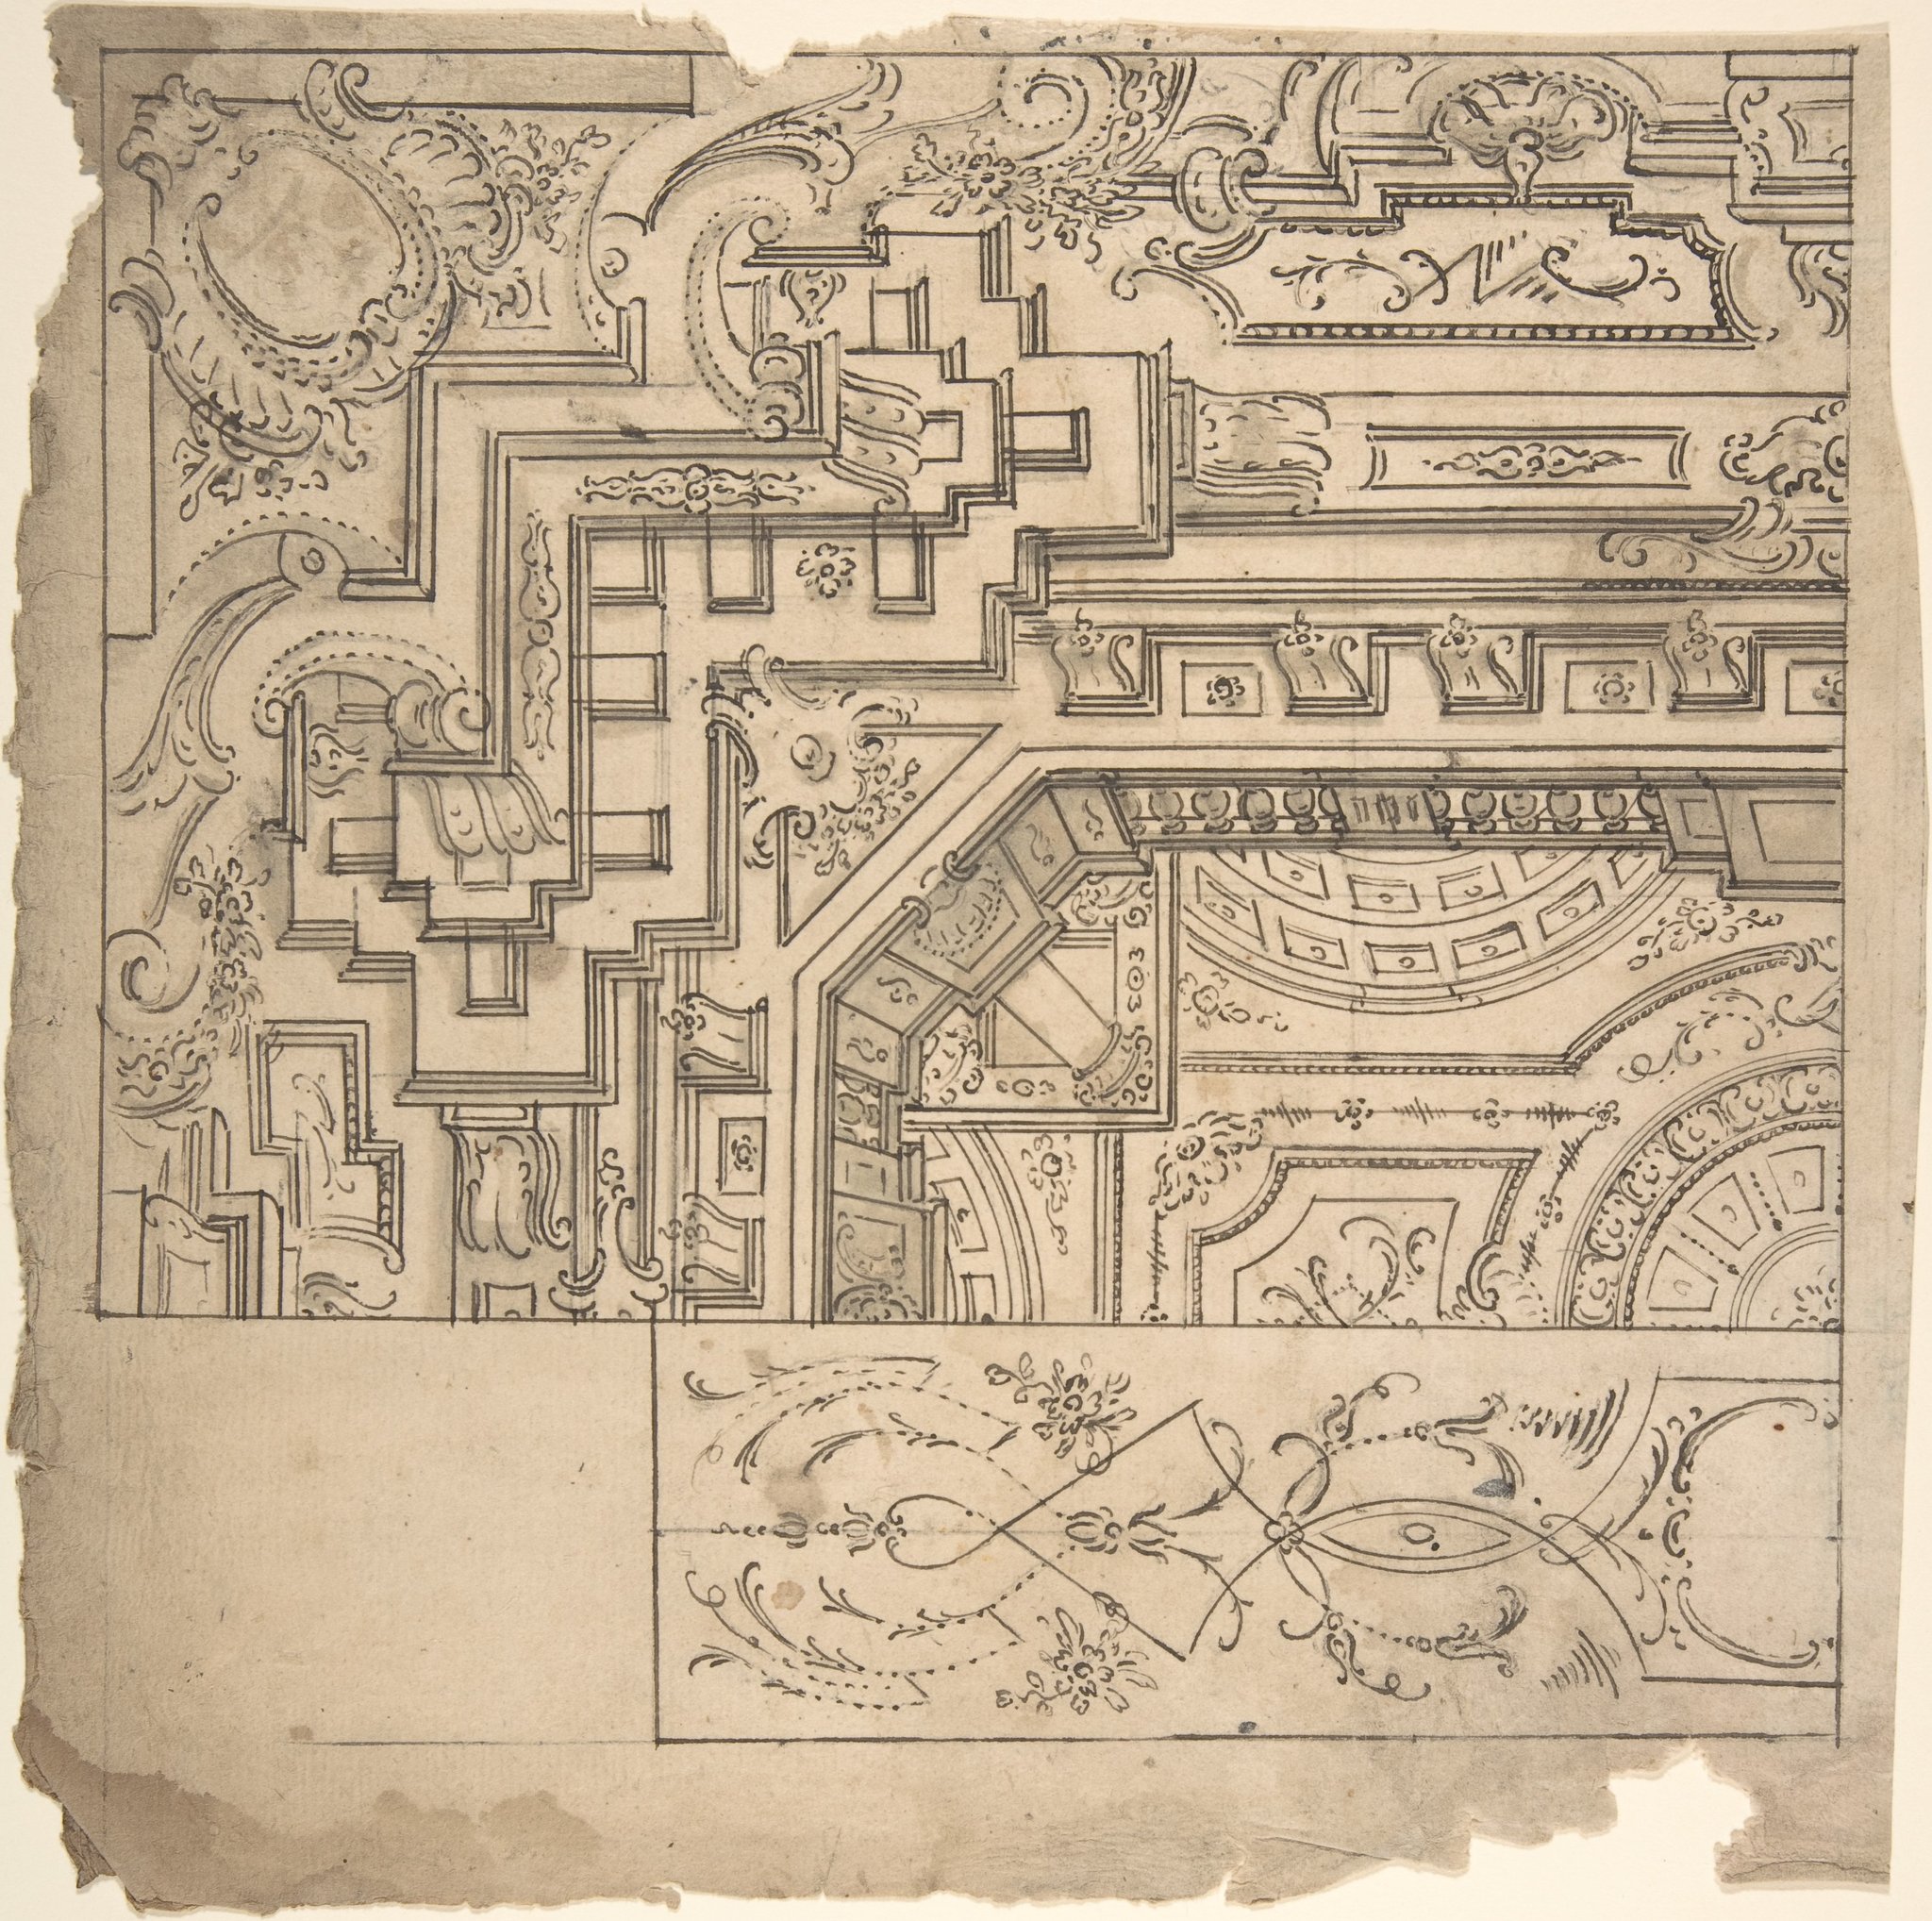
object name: drawing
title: Architectural Drawing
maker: anonymous, italian, 18th century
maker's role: artist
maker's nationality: italian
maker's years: 1700-1800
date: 1701-1800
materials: chalk, ink, paper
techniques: brush, pen, wash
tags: architecture